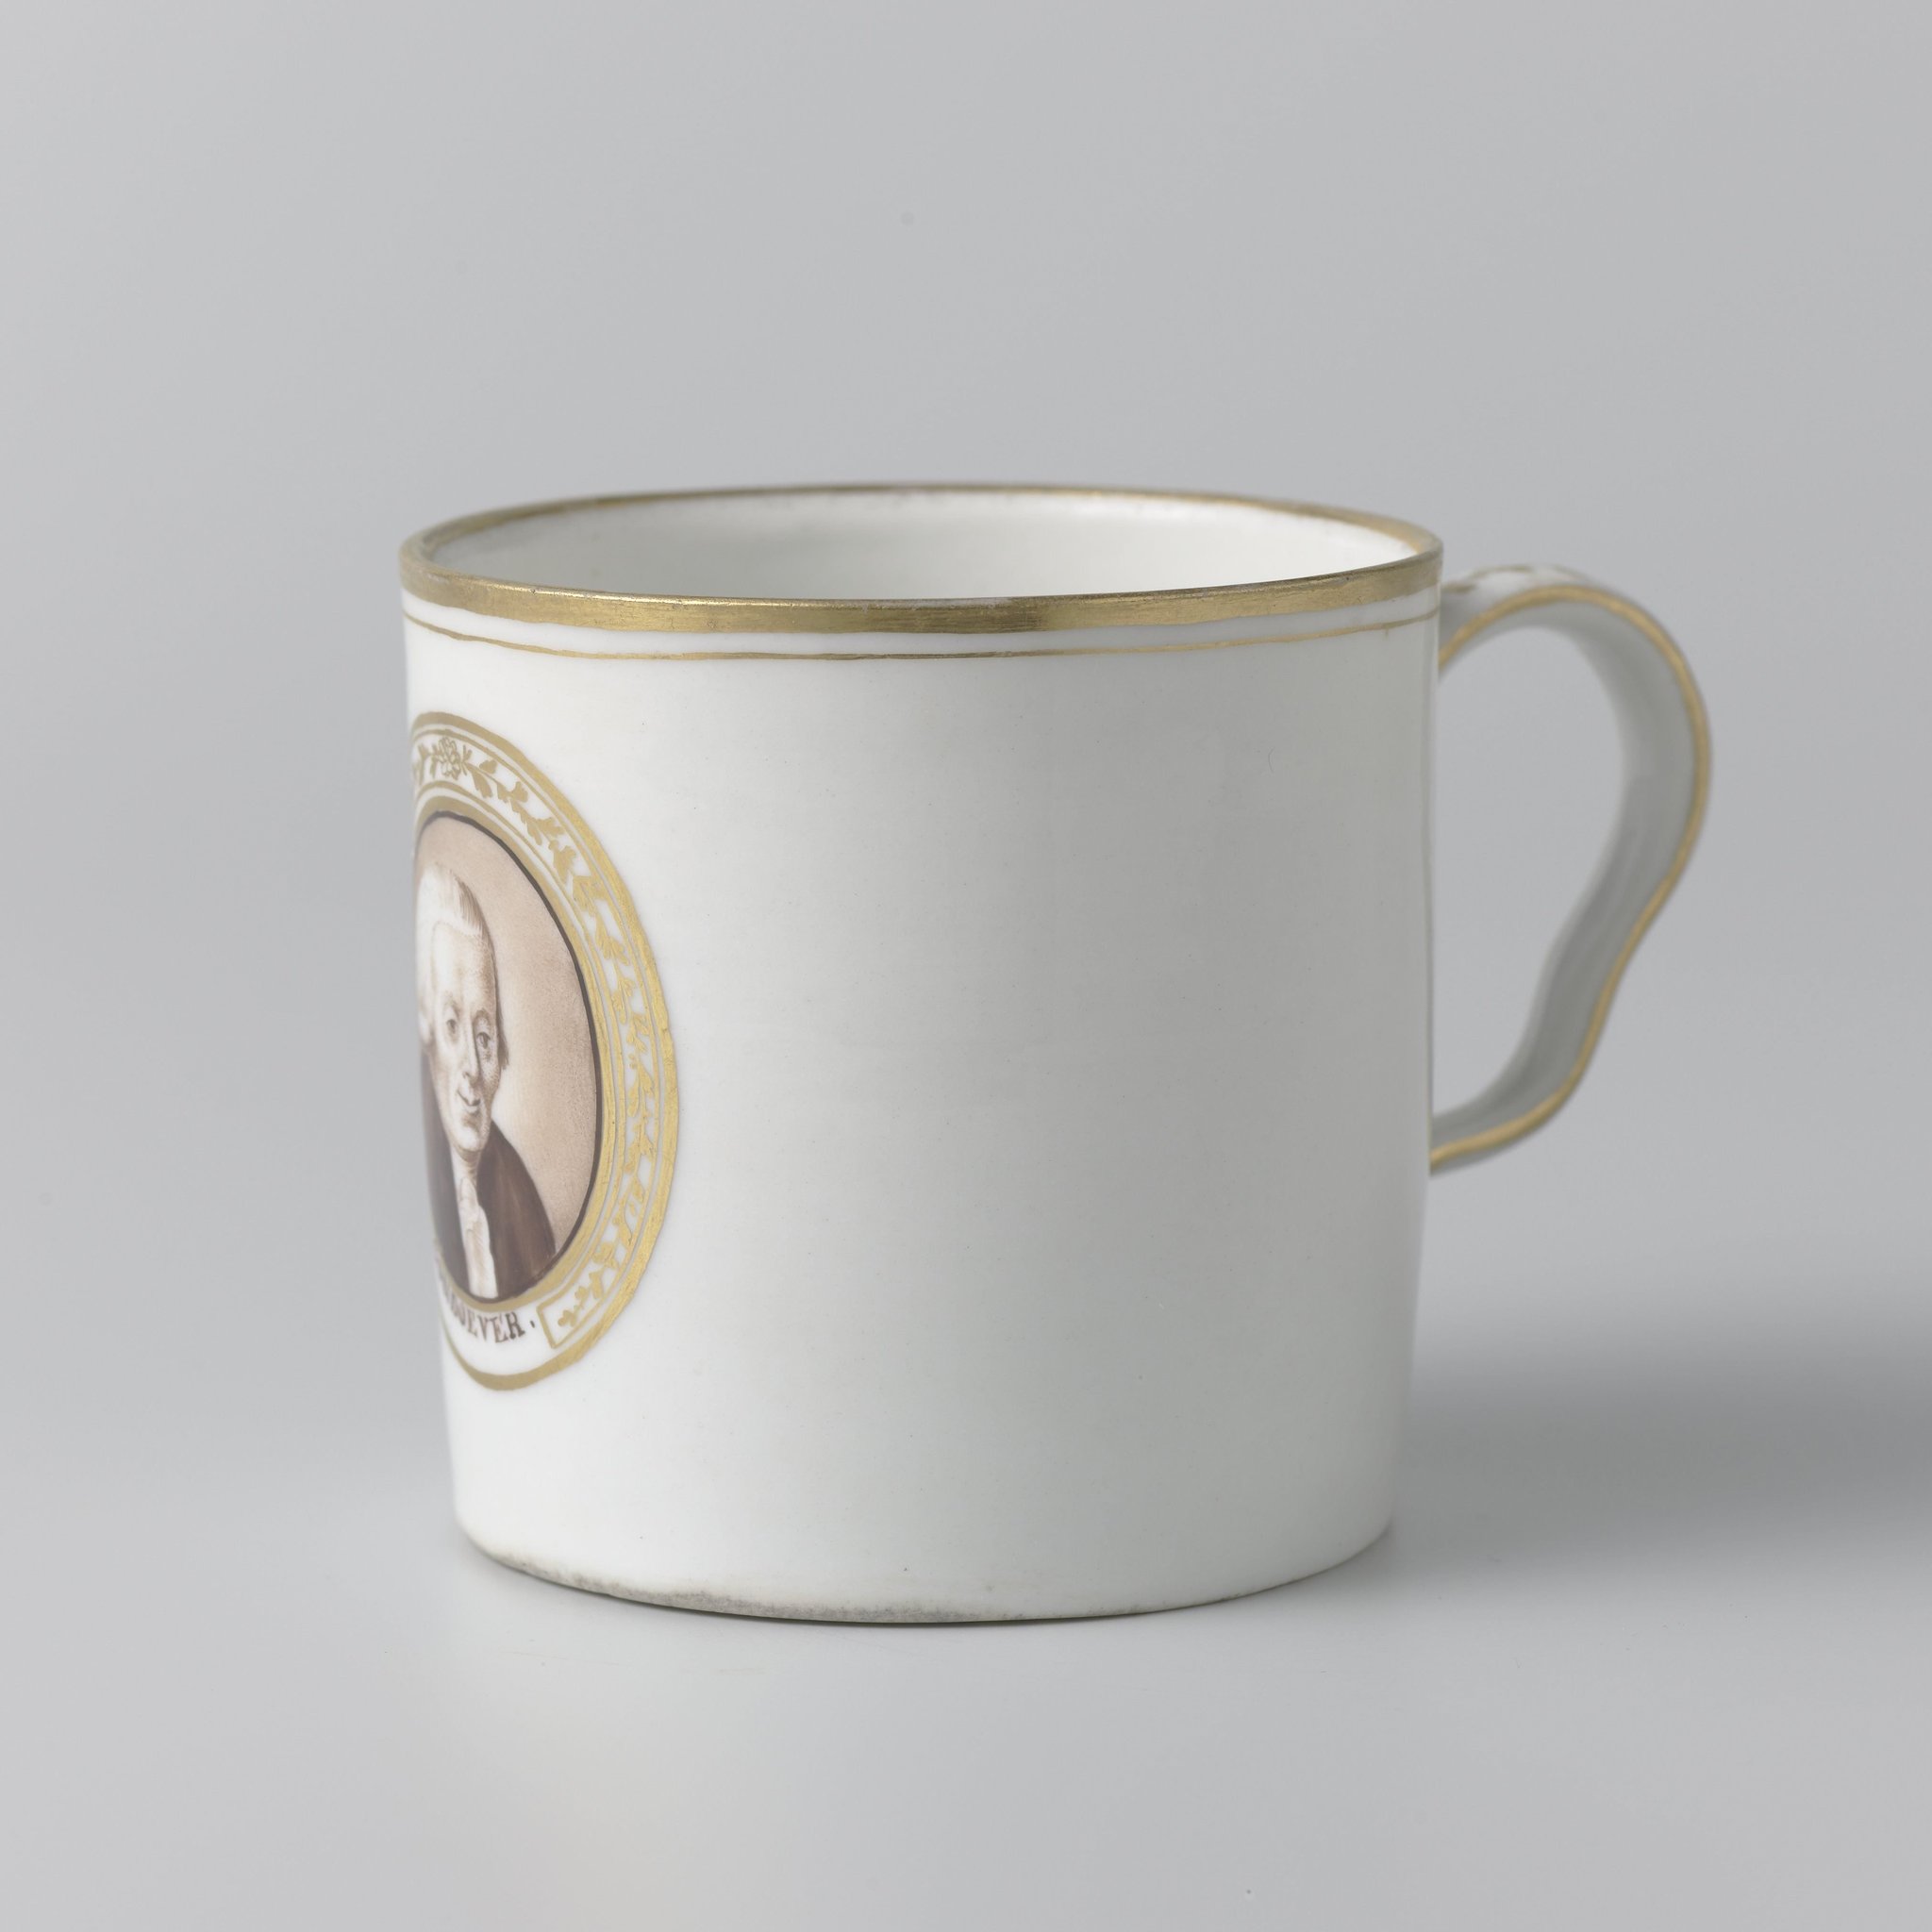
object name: service set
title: Cup with the portrait of Goudoever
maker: Anonymous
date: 1794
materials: glaze, gold, paint, porcelain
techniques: firing, forming, gilding, turning, vitrification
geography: schwarzburg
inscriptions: mark: ‘103-N/ 8’, inscription: ‘GOUDOEVER.’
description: Kop van porselein, beschilderd op het glazuur in sepia en goud. Op de buitenwand een medaillon met een portret. Een band met een bladrank en het opschrift 'SANTHEUVEL' om het medaillon. Gouden rand en een bladrank op het oor. Gemerkt op de onderzijde met 103-N en 8.